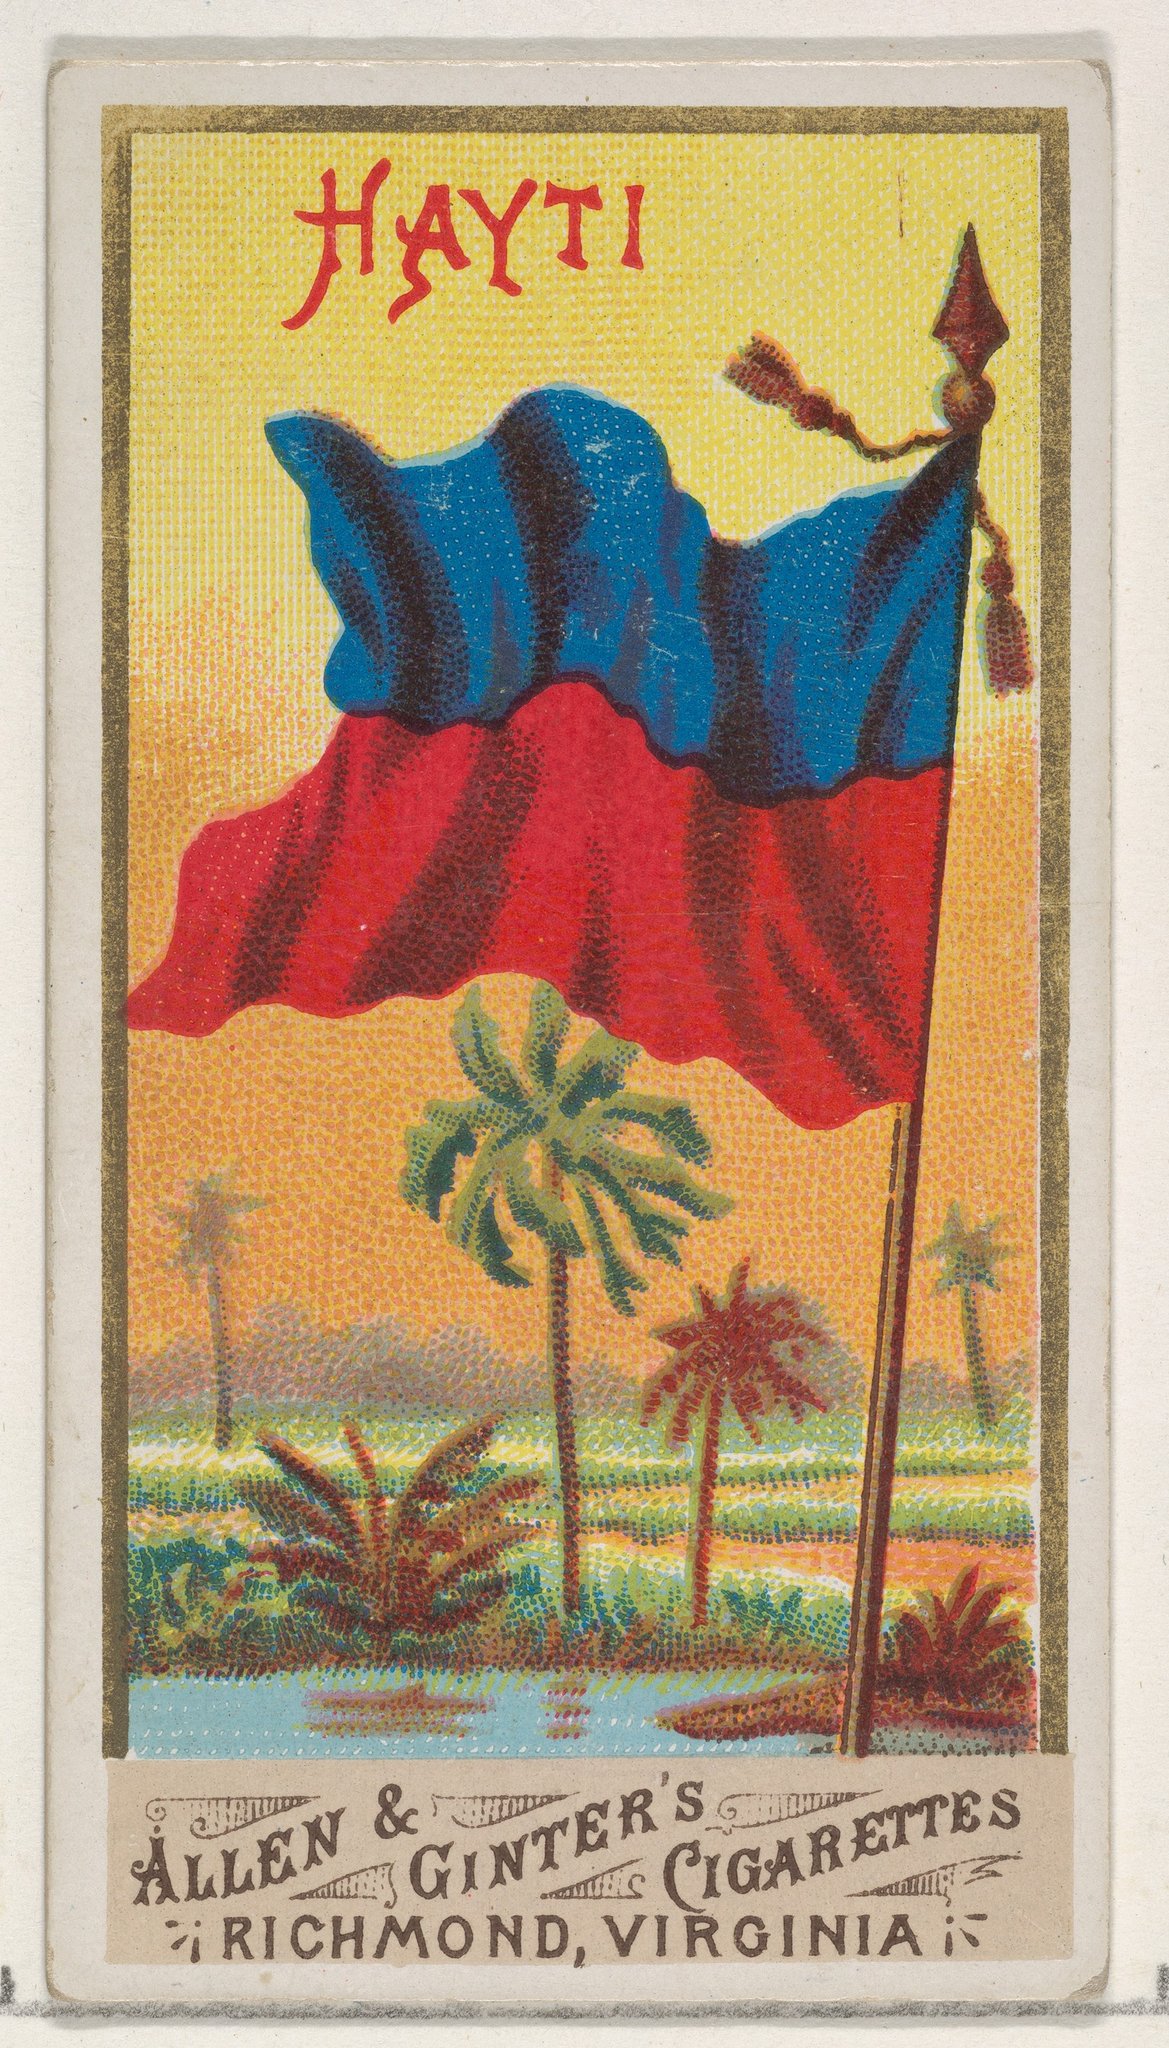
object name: print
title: Haiti, from Flags of All Nations, Series 1 (N9) for Allen & Ginter Cigarettes Brands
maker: allen & ginter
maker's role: publisher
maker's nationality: american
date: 1887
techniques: color lithograph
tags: flags